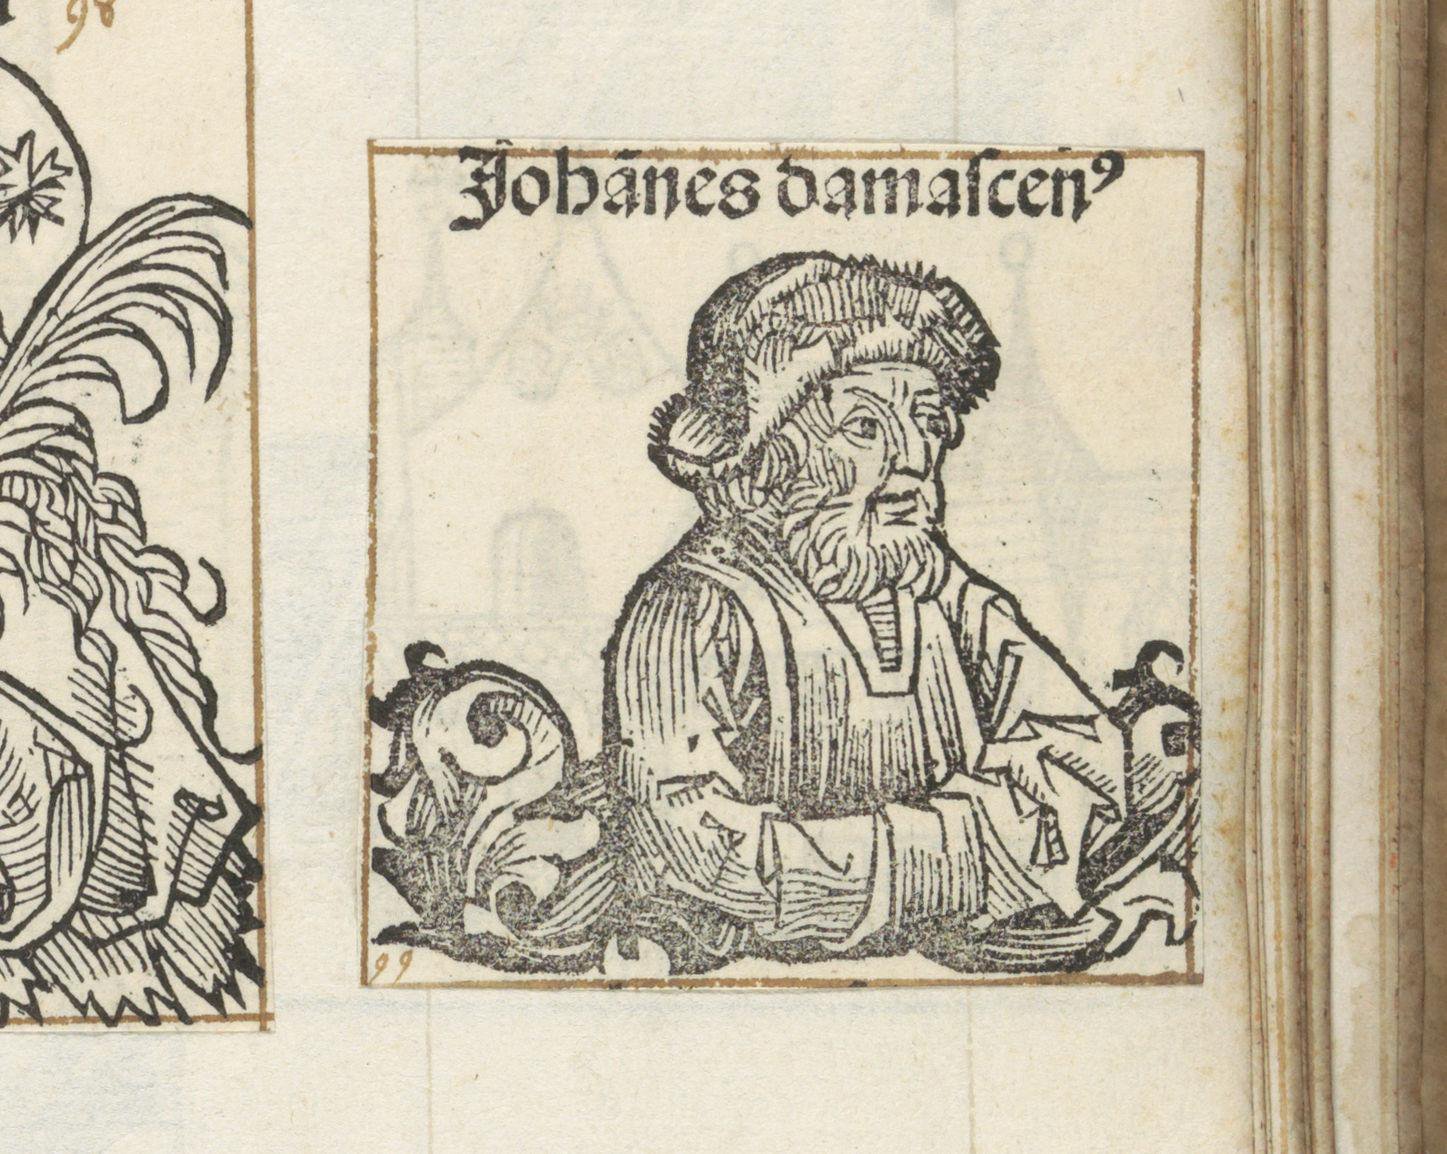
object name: print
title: Liber Chronicarum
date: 1493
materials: paper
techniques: letterpress printing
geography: nuremberg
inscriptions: inscription: ‘99’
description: De houtsnede wordt gebruikt als boekillustratie in de Liber Chronicarum (of Neurenbergkroniek) van Hartmann Schedel, verschenen in het Latijn en Duits in 1493. Zie de Latijnse uitgave, folio 138r.